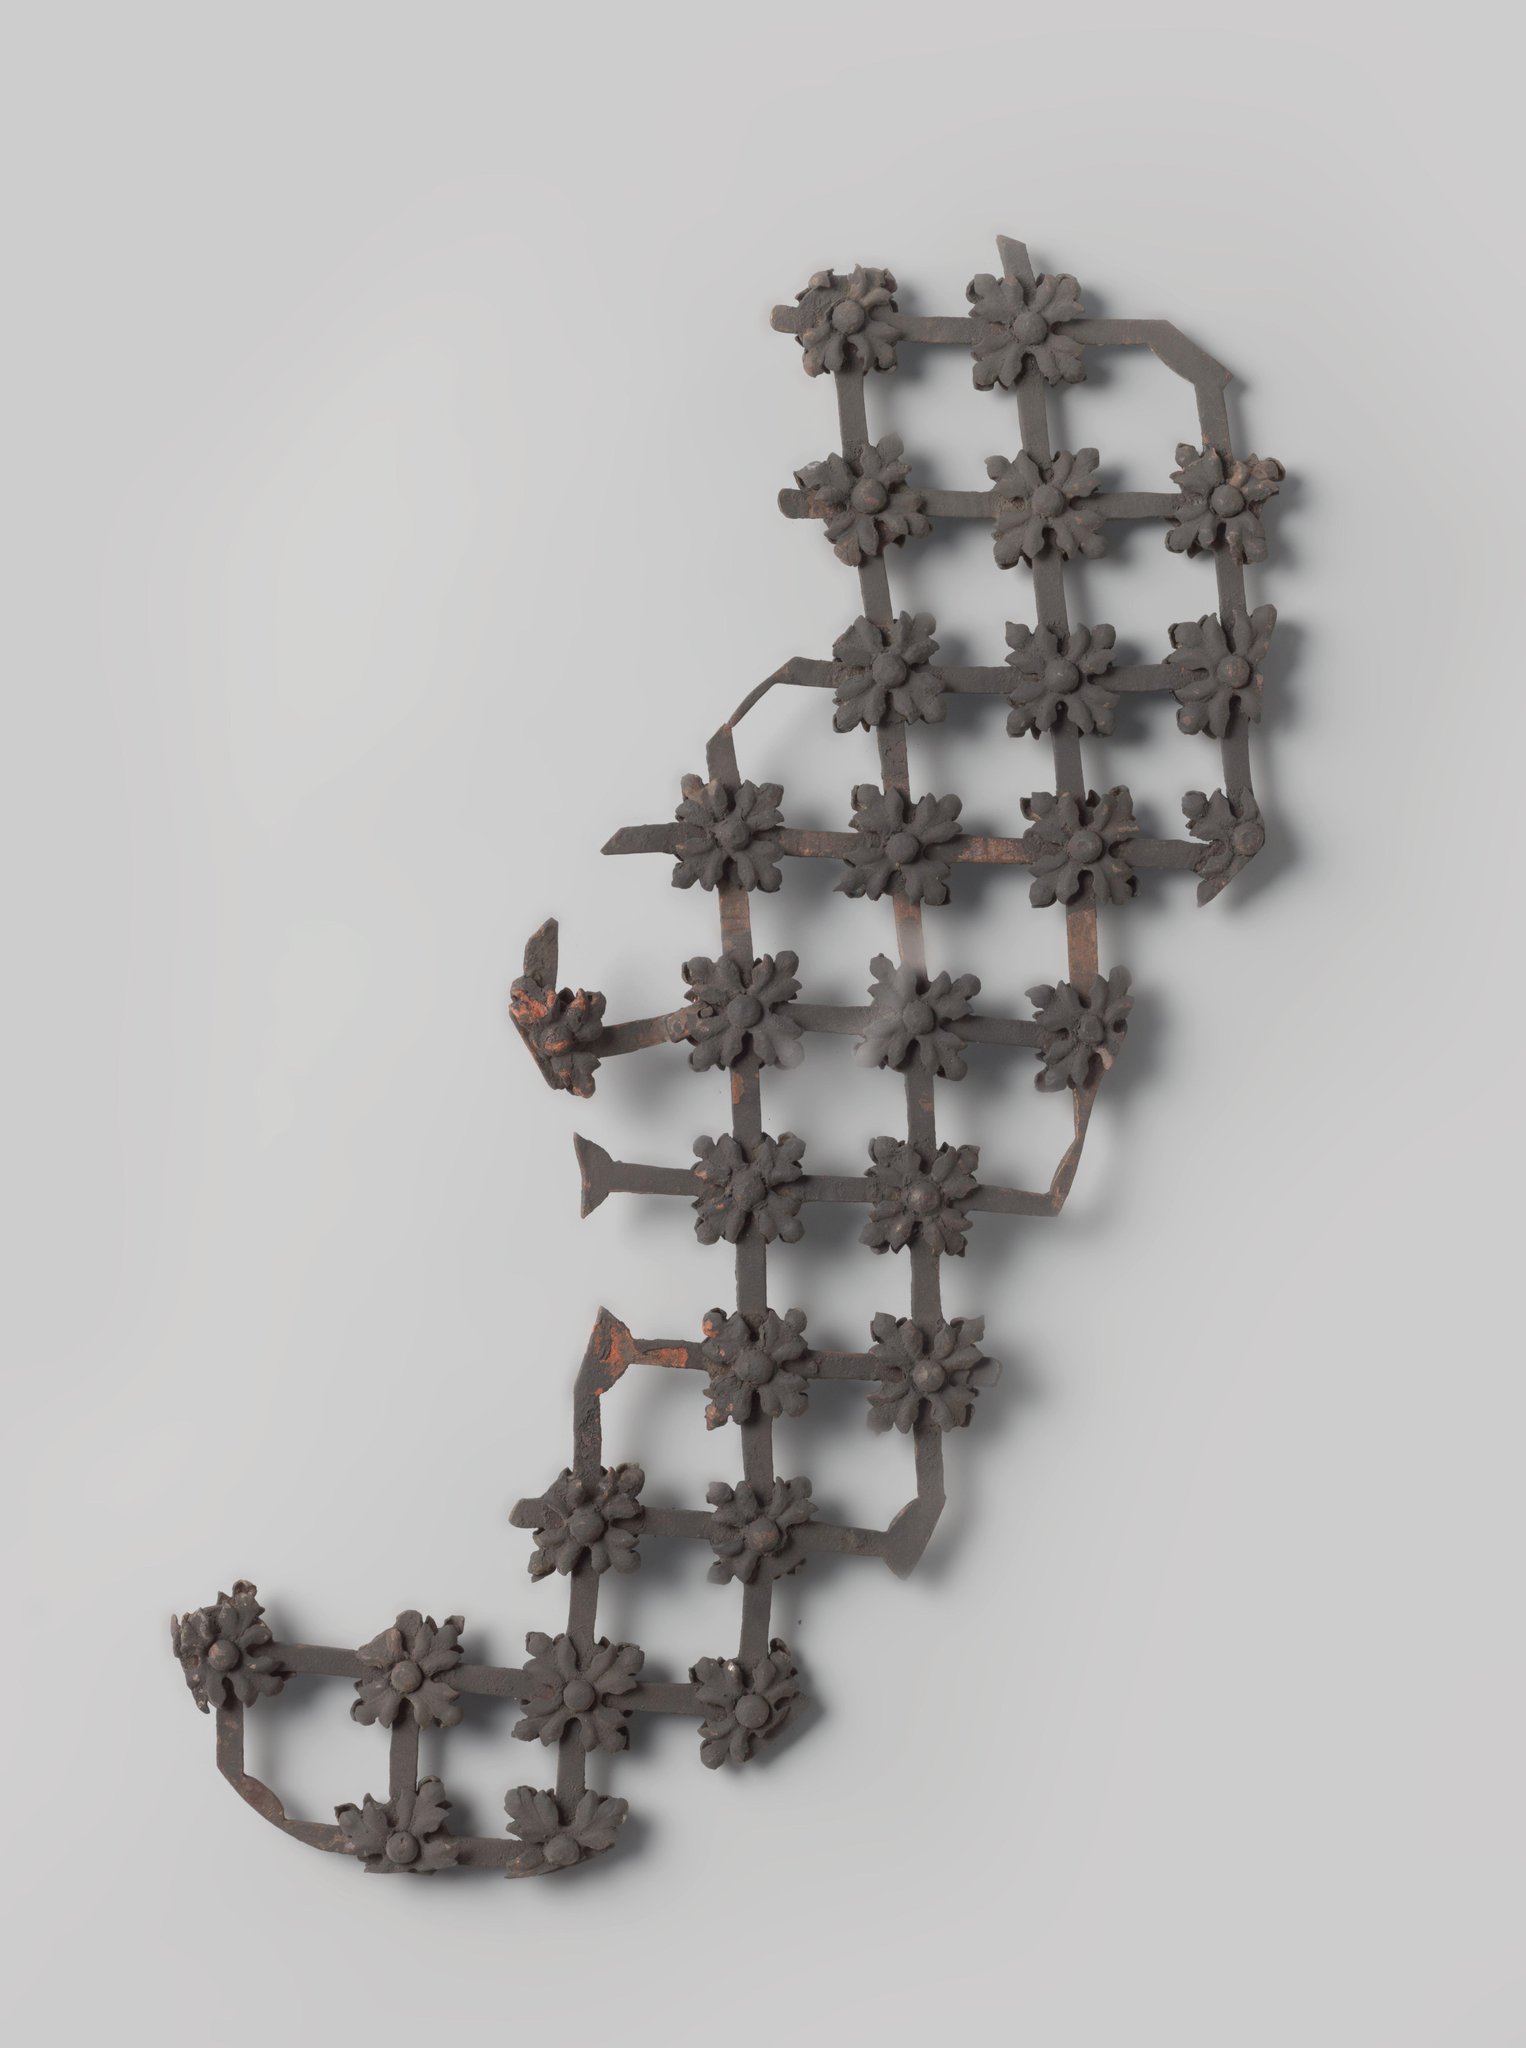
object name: uithangteken, uithangbord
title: Siertraliewerk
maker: Anonymous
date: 1700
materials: iron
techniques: forging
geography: amsterdam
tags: amsterdam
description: Siertraliewerk. Onderdeel van een uithangteken van een smederij in de Beulingstraat te Amsterdam.